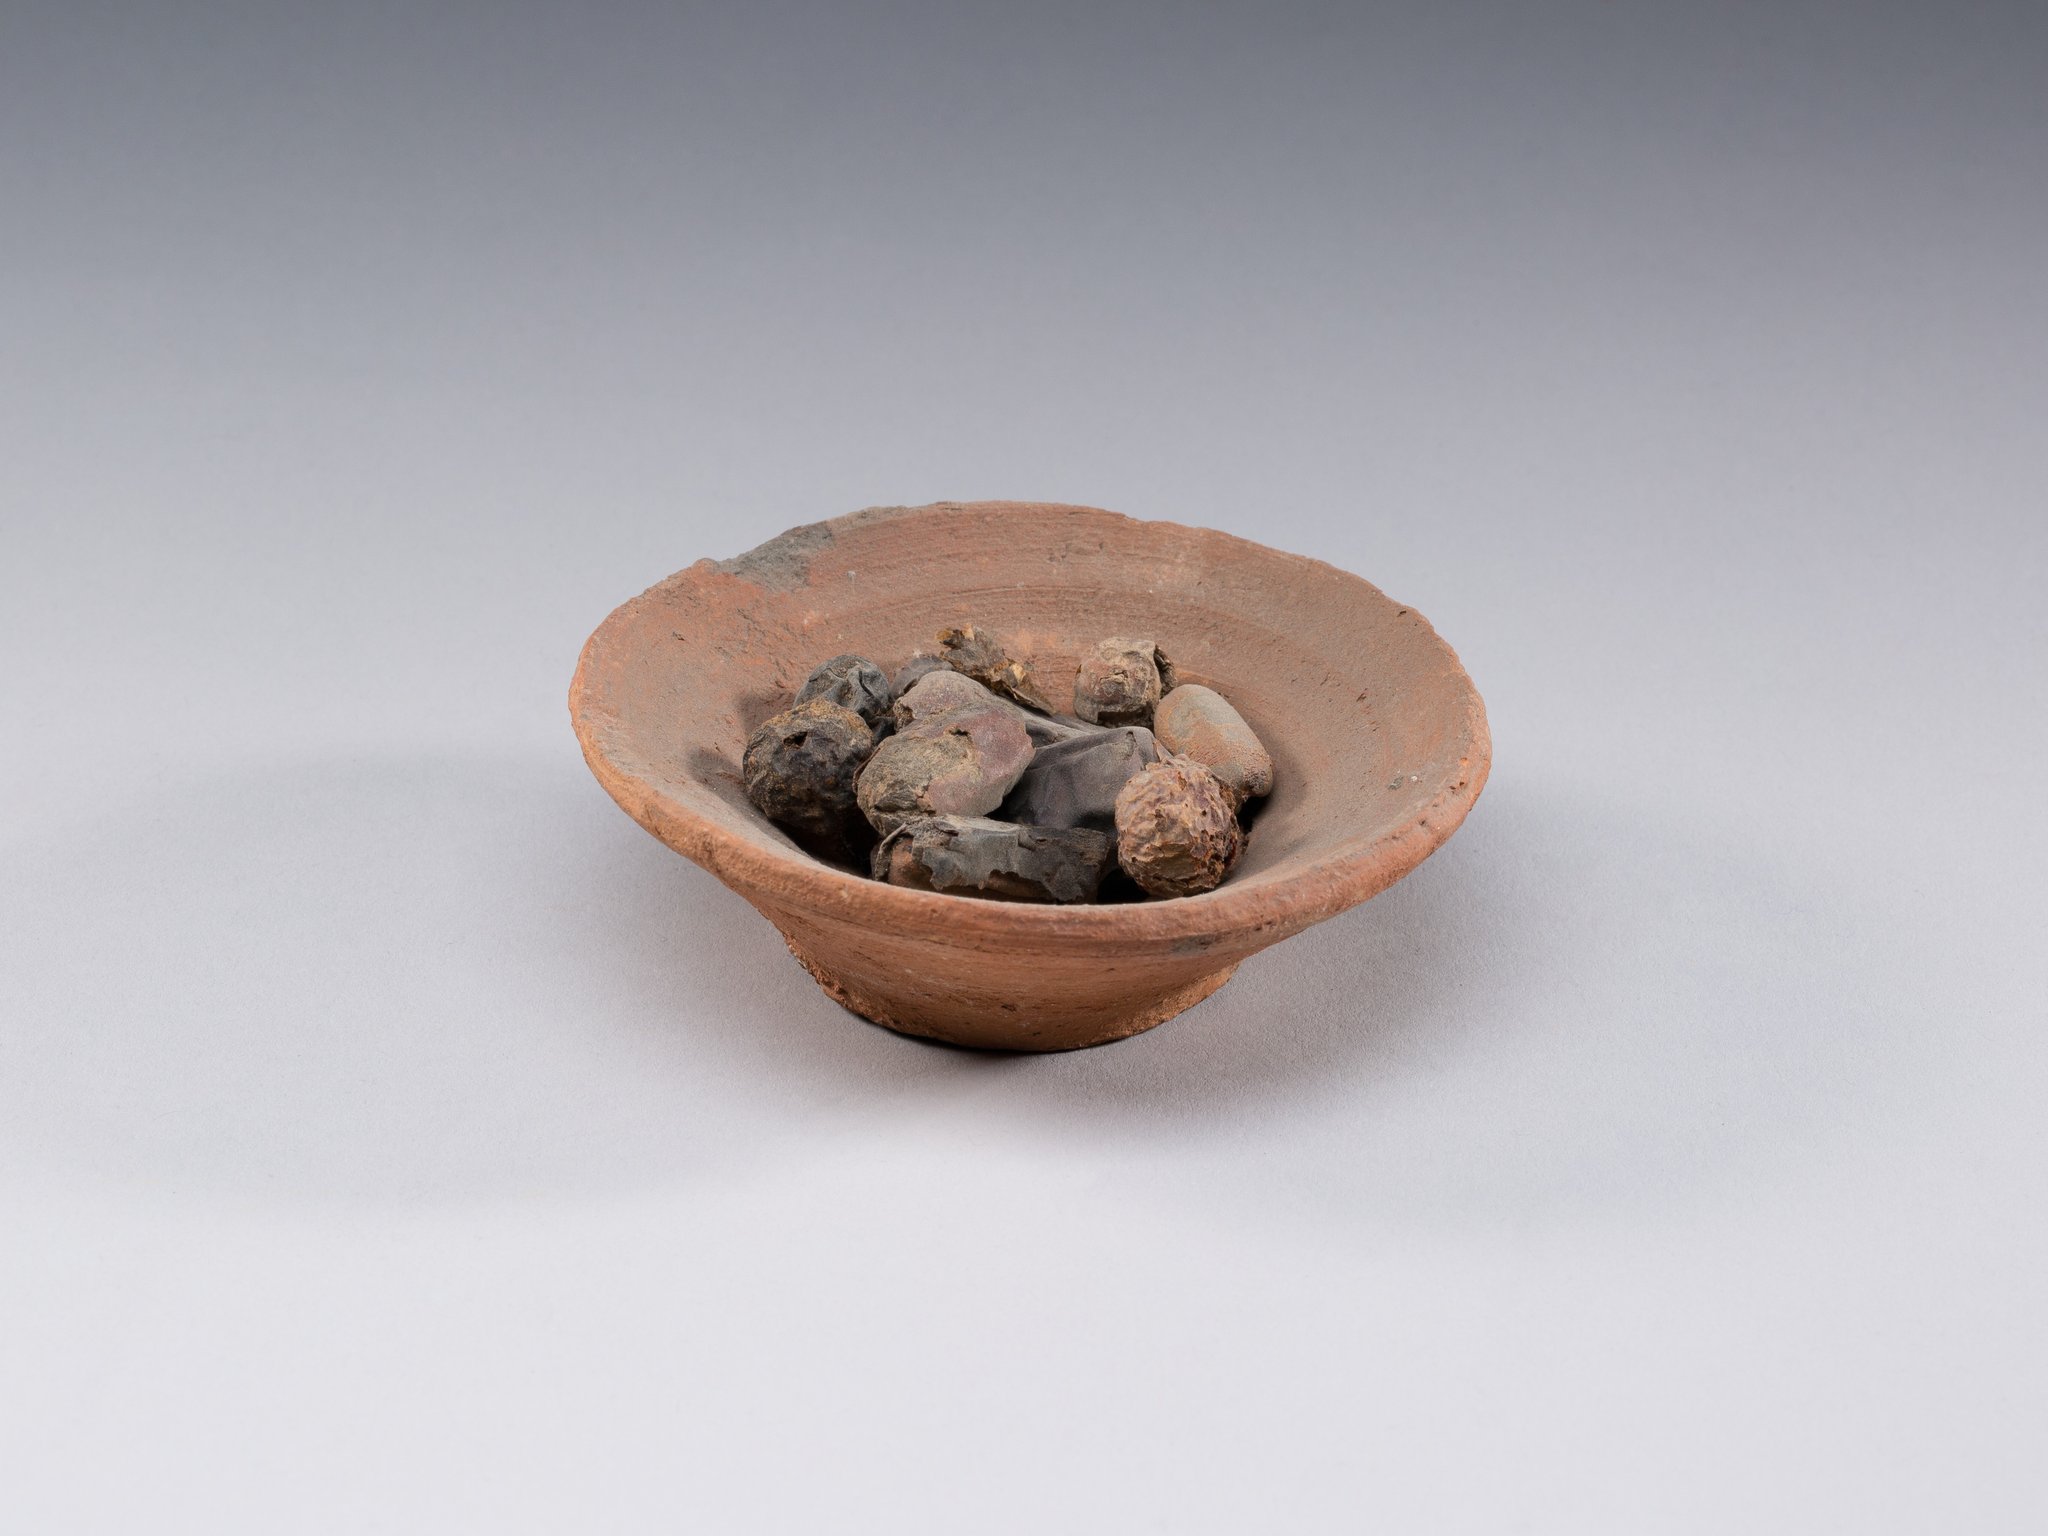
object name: bowl, food, date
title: Bowl of Dates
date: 1479-1458 BCE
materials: pottery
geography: egypt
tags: fruit